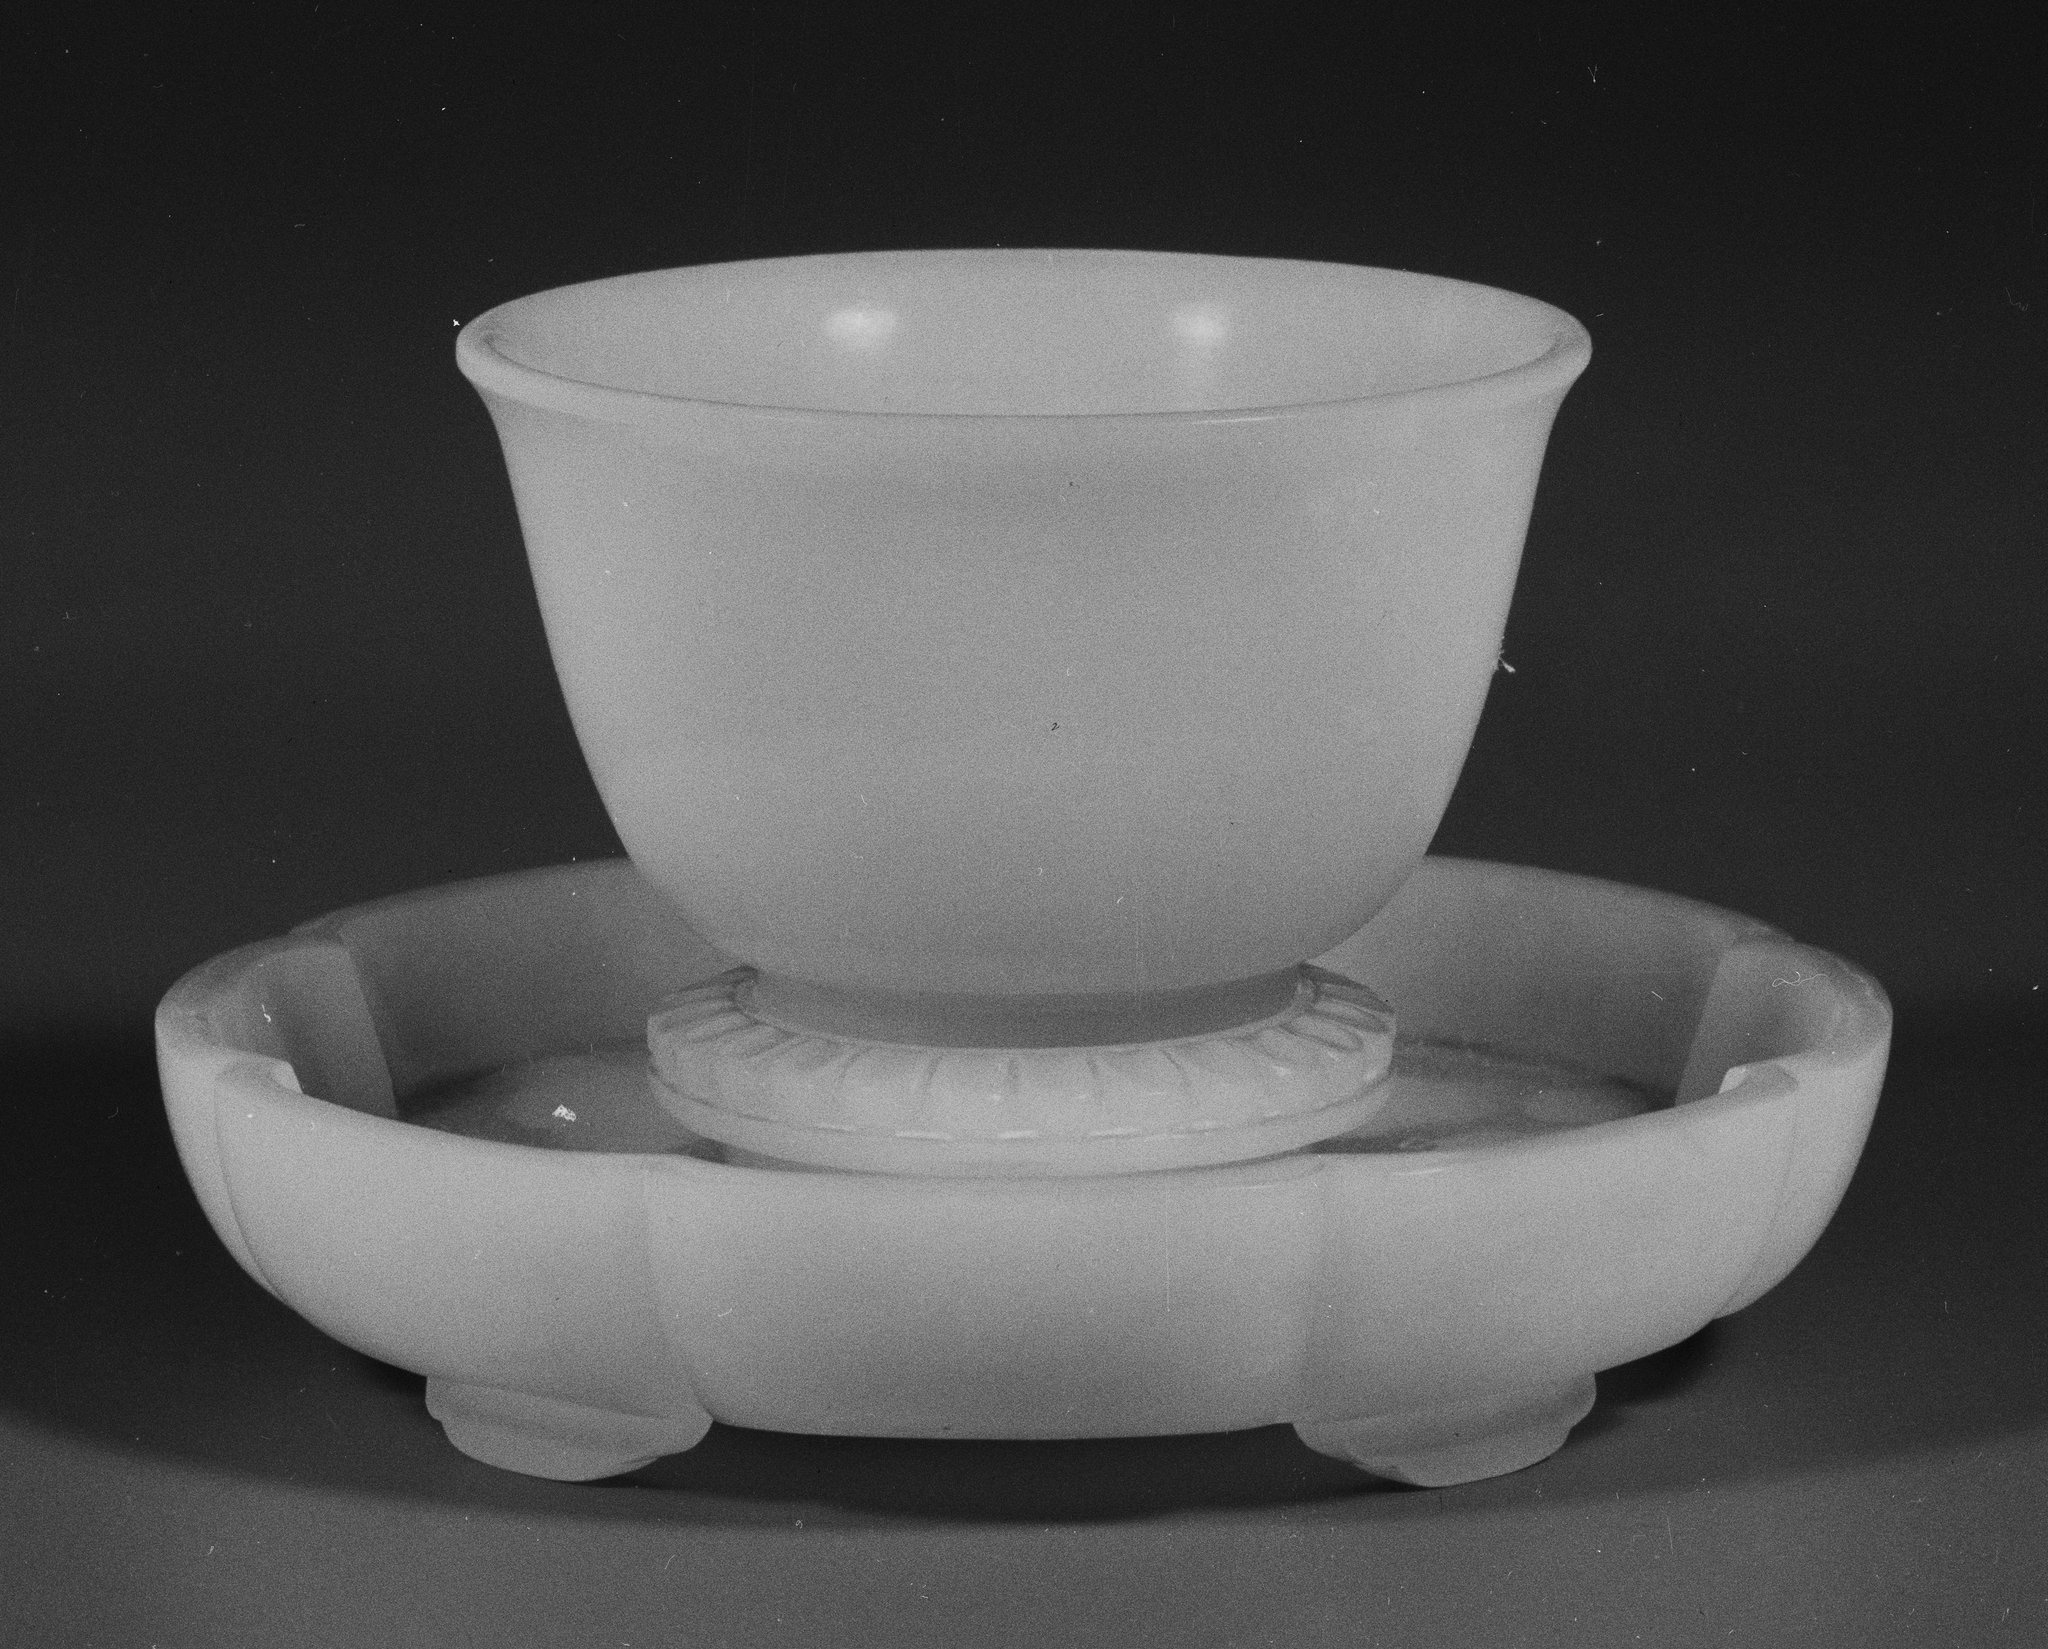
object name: cup and saucer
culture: chinese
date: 1767-1833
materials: jade